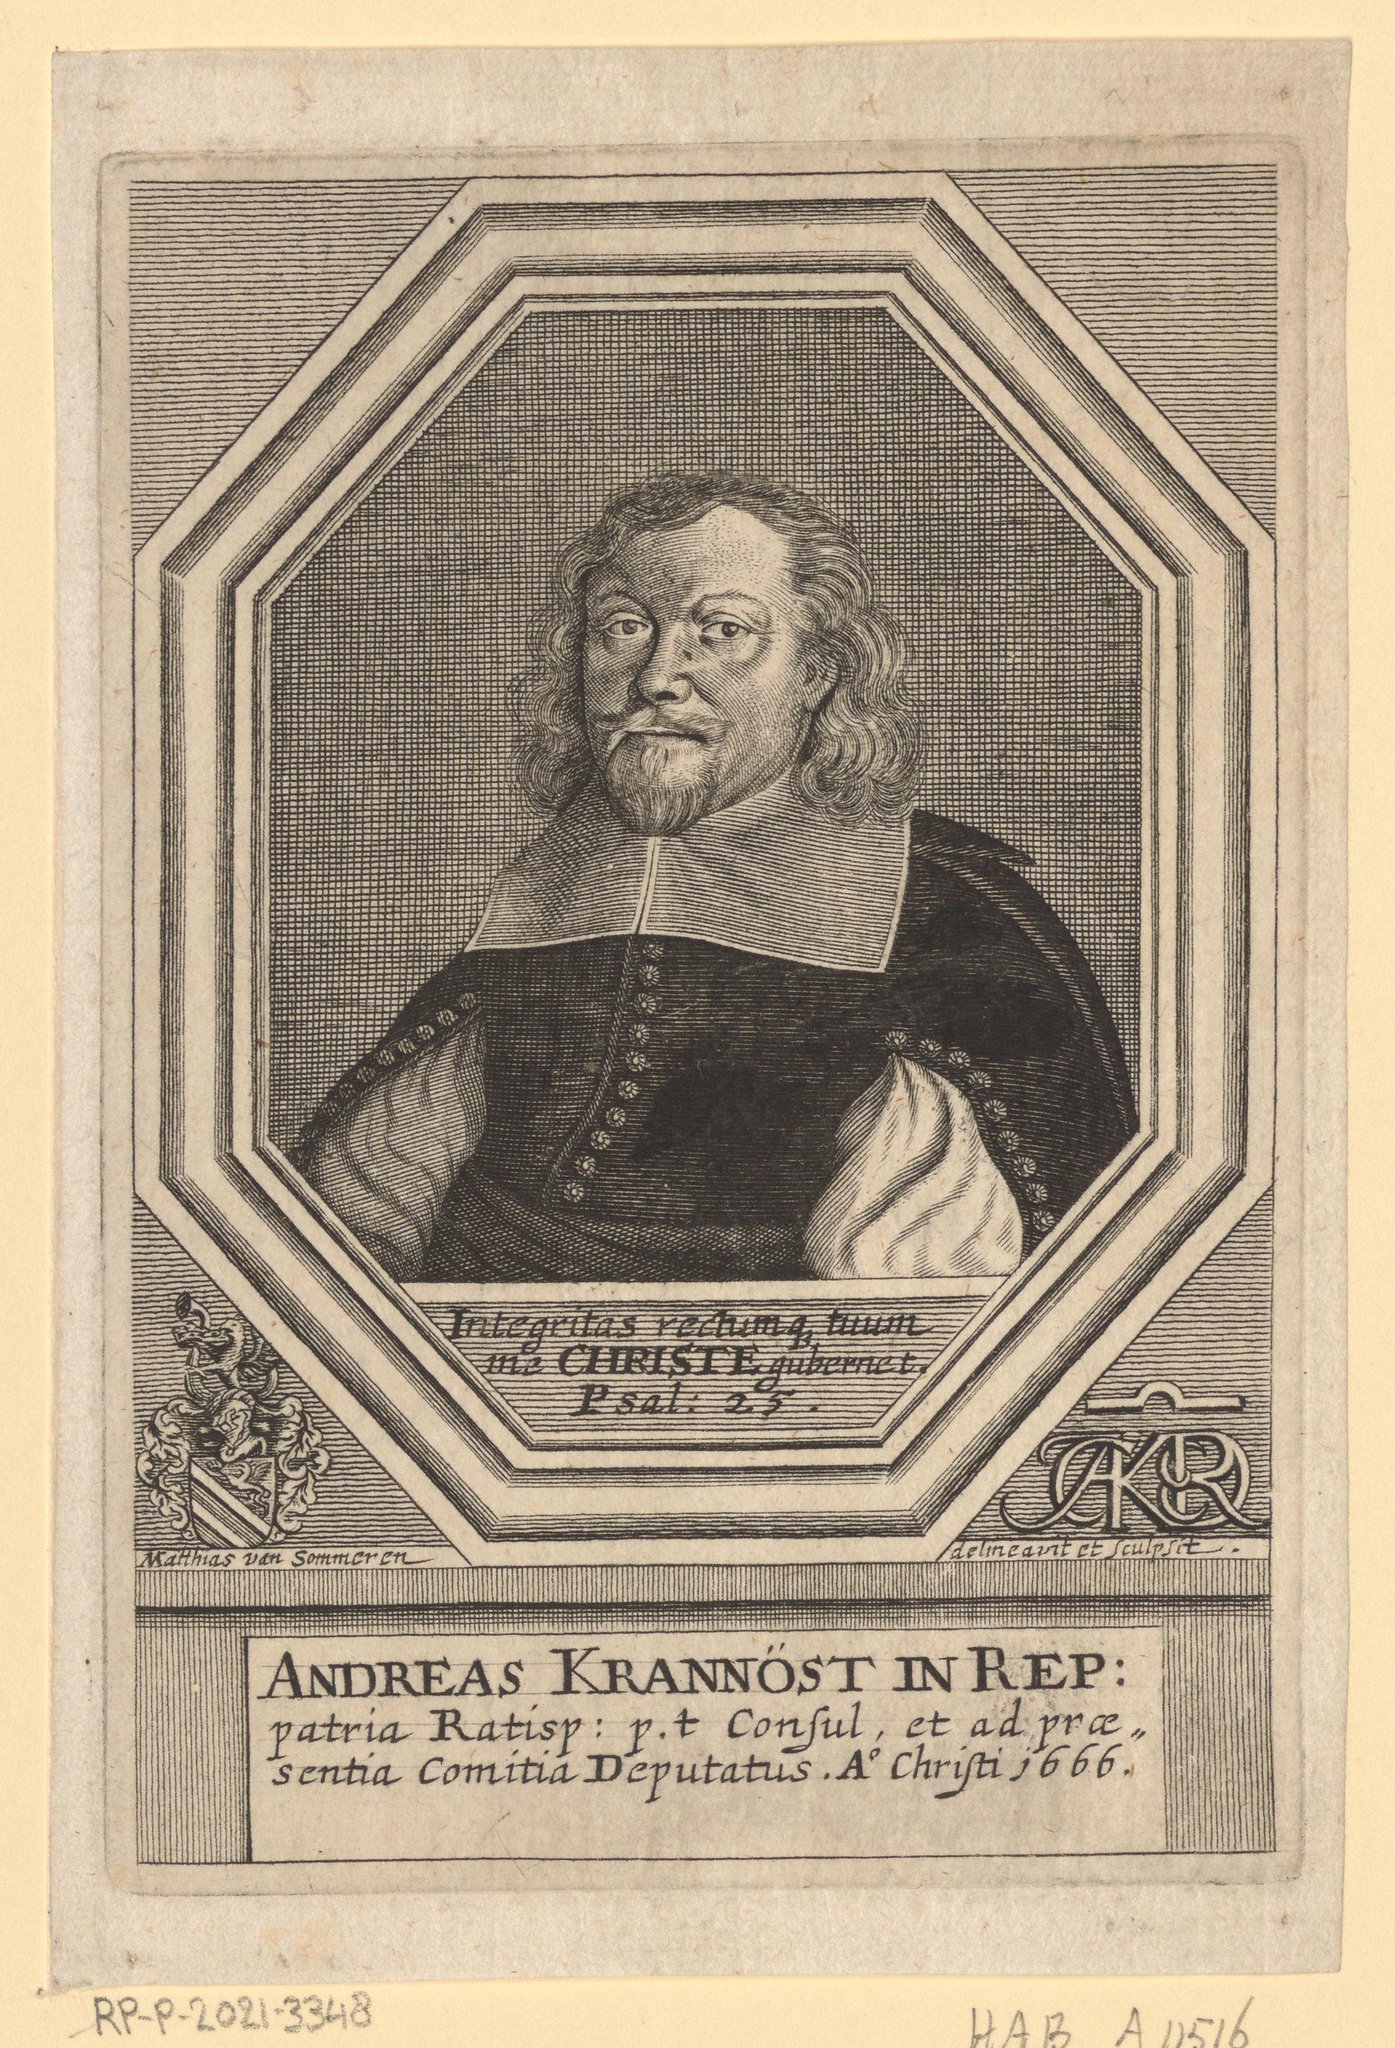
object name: print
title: Portret van Andreas Krannöst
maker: matthias van sommer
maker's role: draughtsman, print maker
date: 1667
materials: paper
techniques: engraving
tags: mayor, andreas krannöst, historical persons, armorial bearing, heraldry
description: Prent mogelijk uit: Sommer, Matthias van. Hasce omnium electorum principum ac statuum Sacri Romani Imperii ad comitia praesentia legatis ac deputatis icones (…). Regensburg: Matthias van Sommer, [1667-1671]. Alhoewel op de titelpagina van de publicatie het jaar 1667 wordt vermeld, zijn meerdere prenten later gedateerd. Waarschijnlijk werd de publicatie pas in 1671 daadwerkelijk uitgegeven.